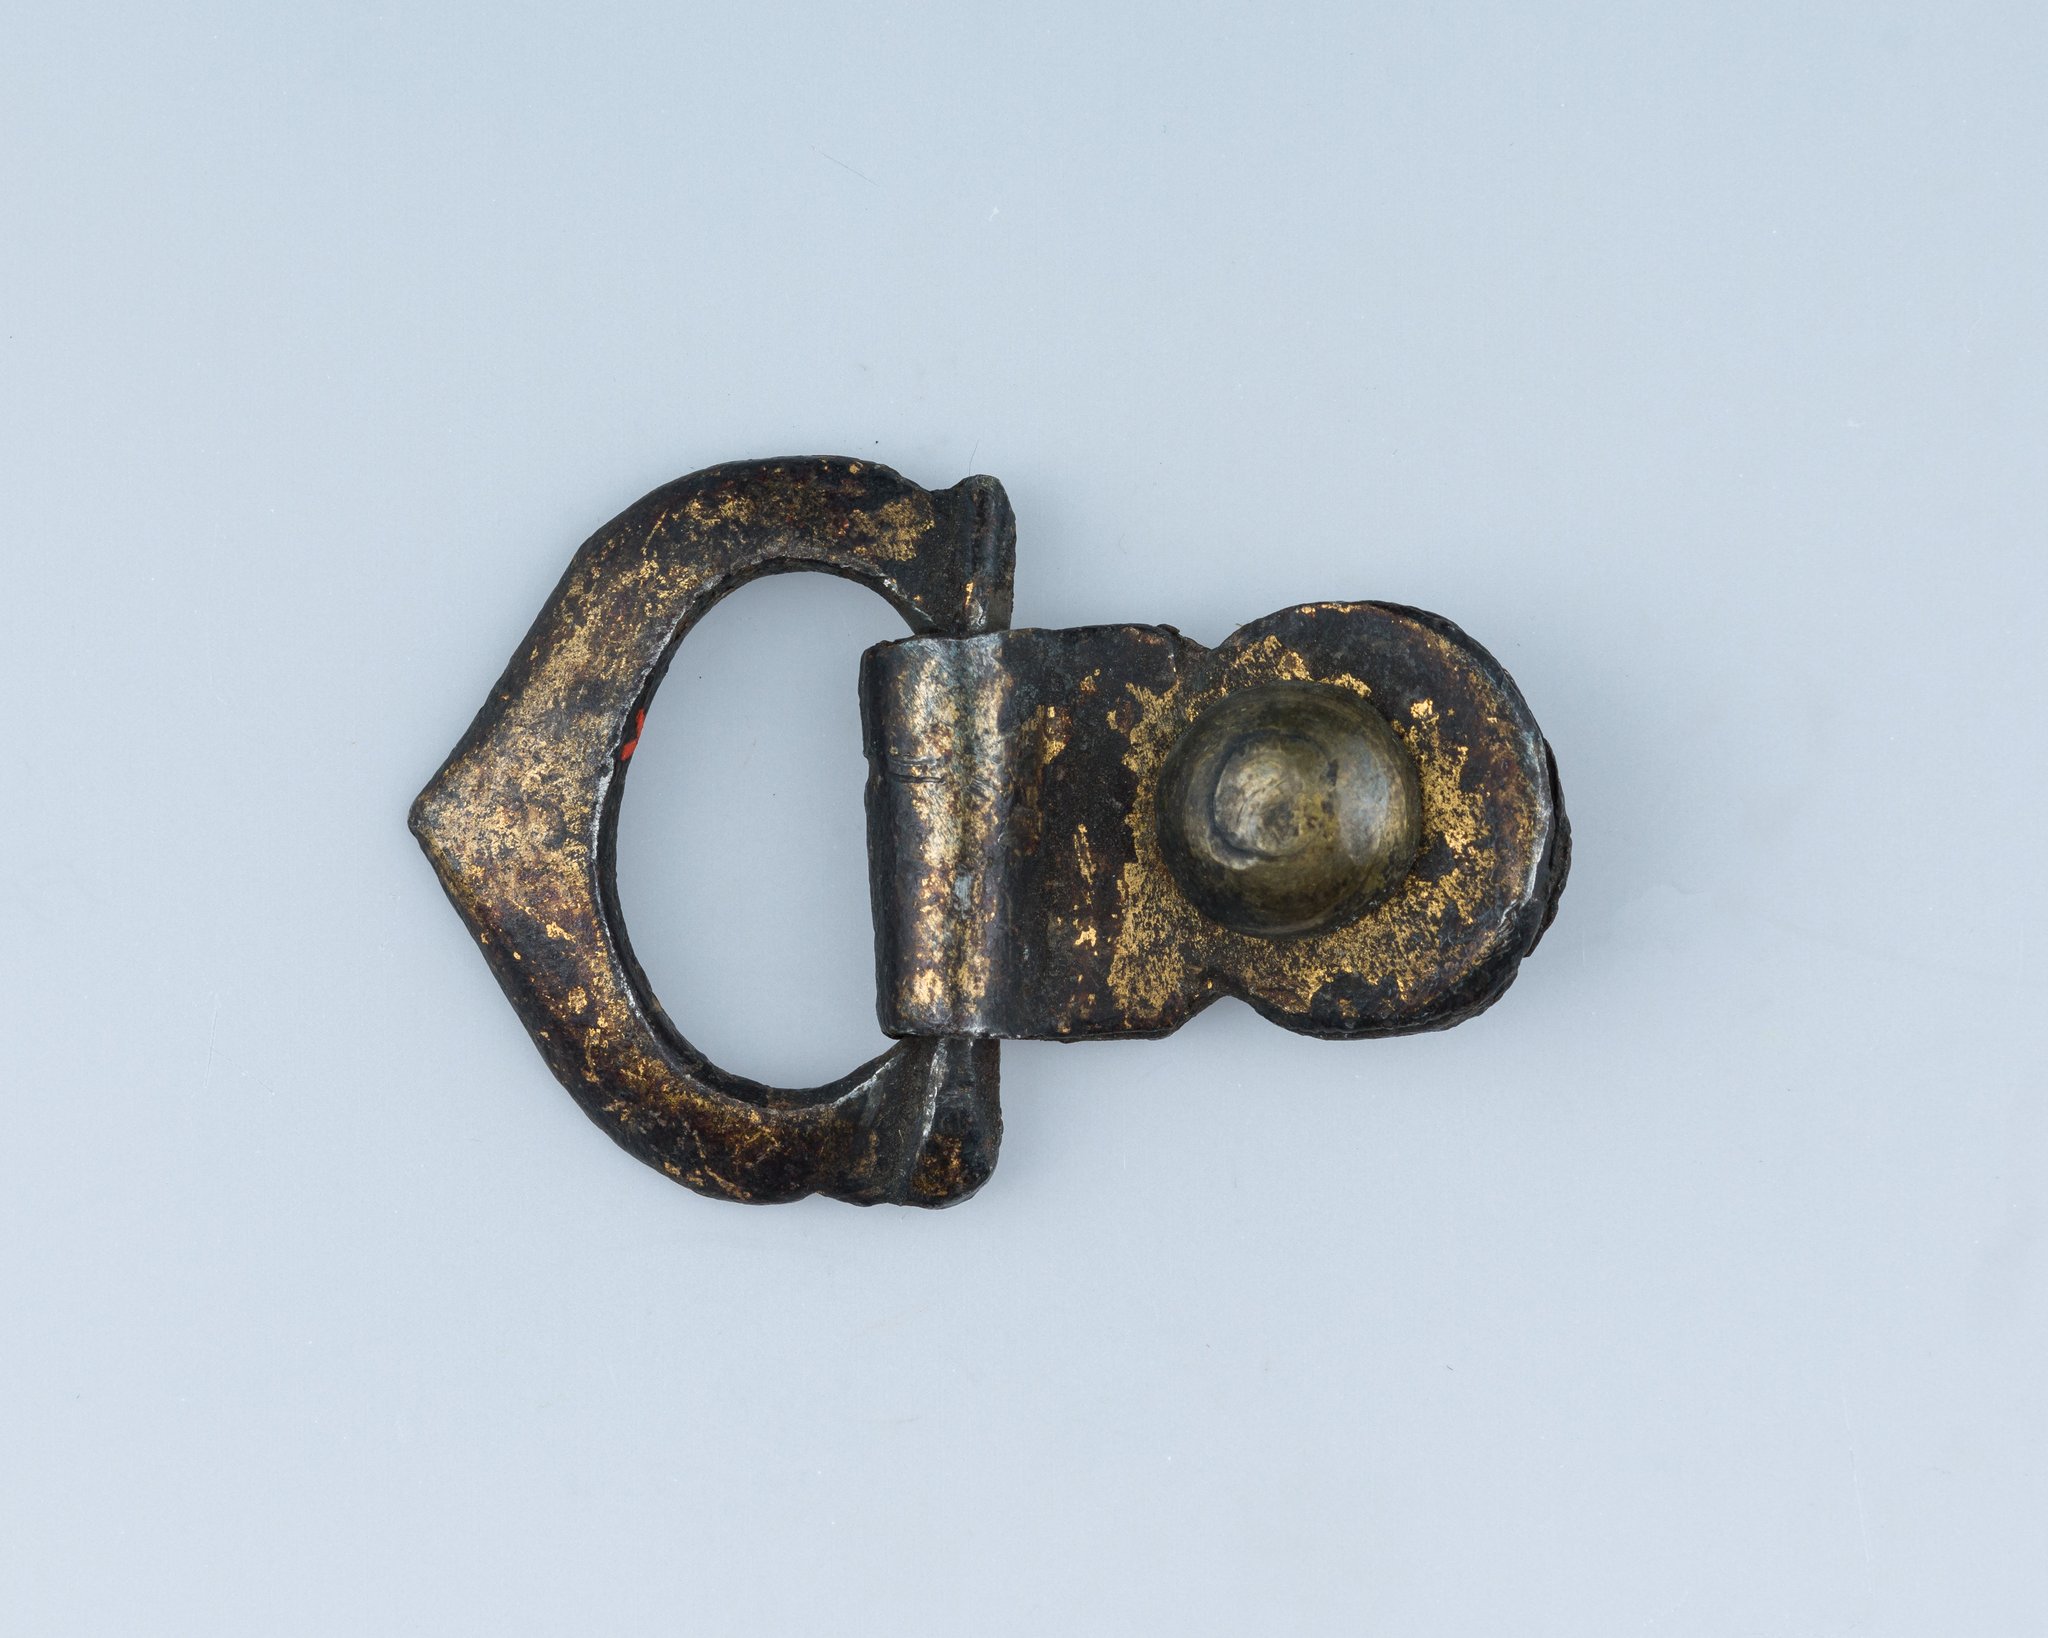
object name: buckle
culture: italian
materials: brass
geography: italy